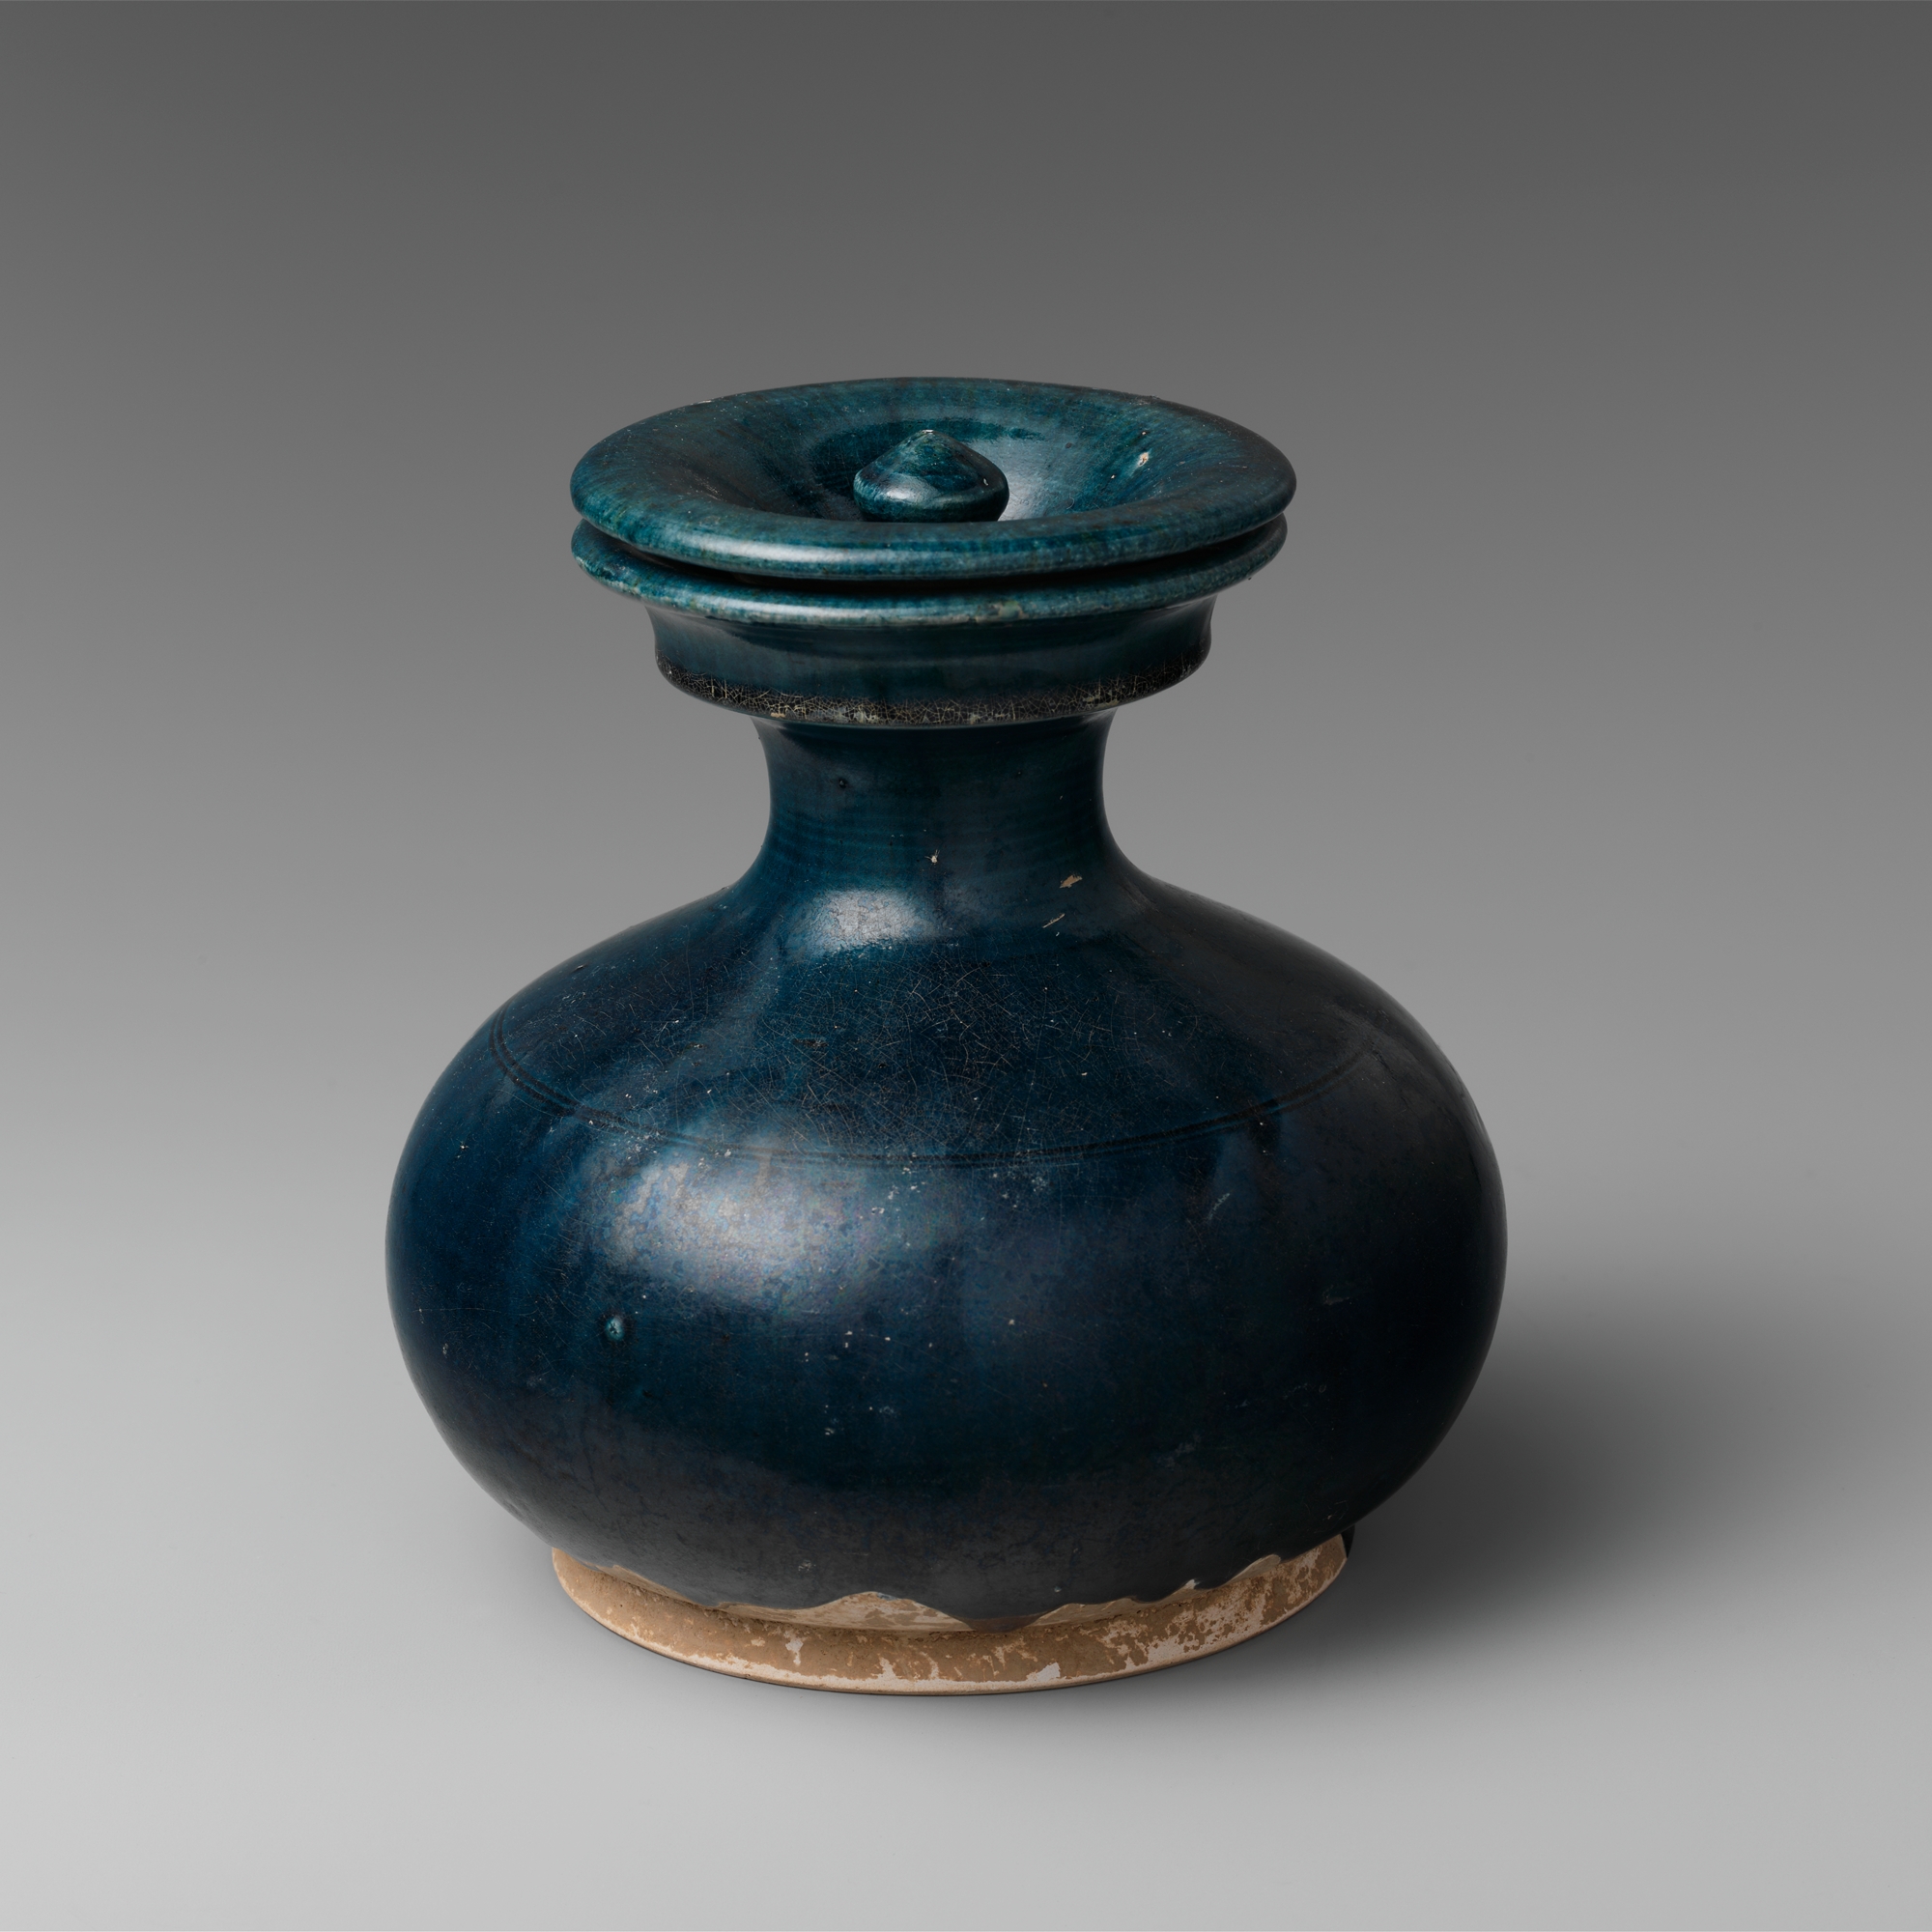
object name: covered jar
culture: chinese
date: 601-700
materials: earthenware, glaze